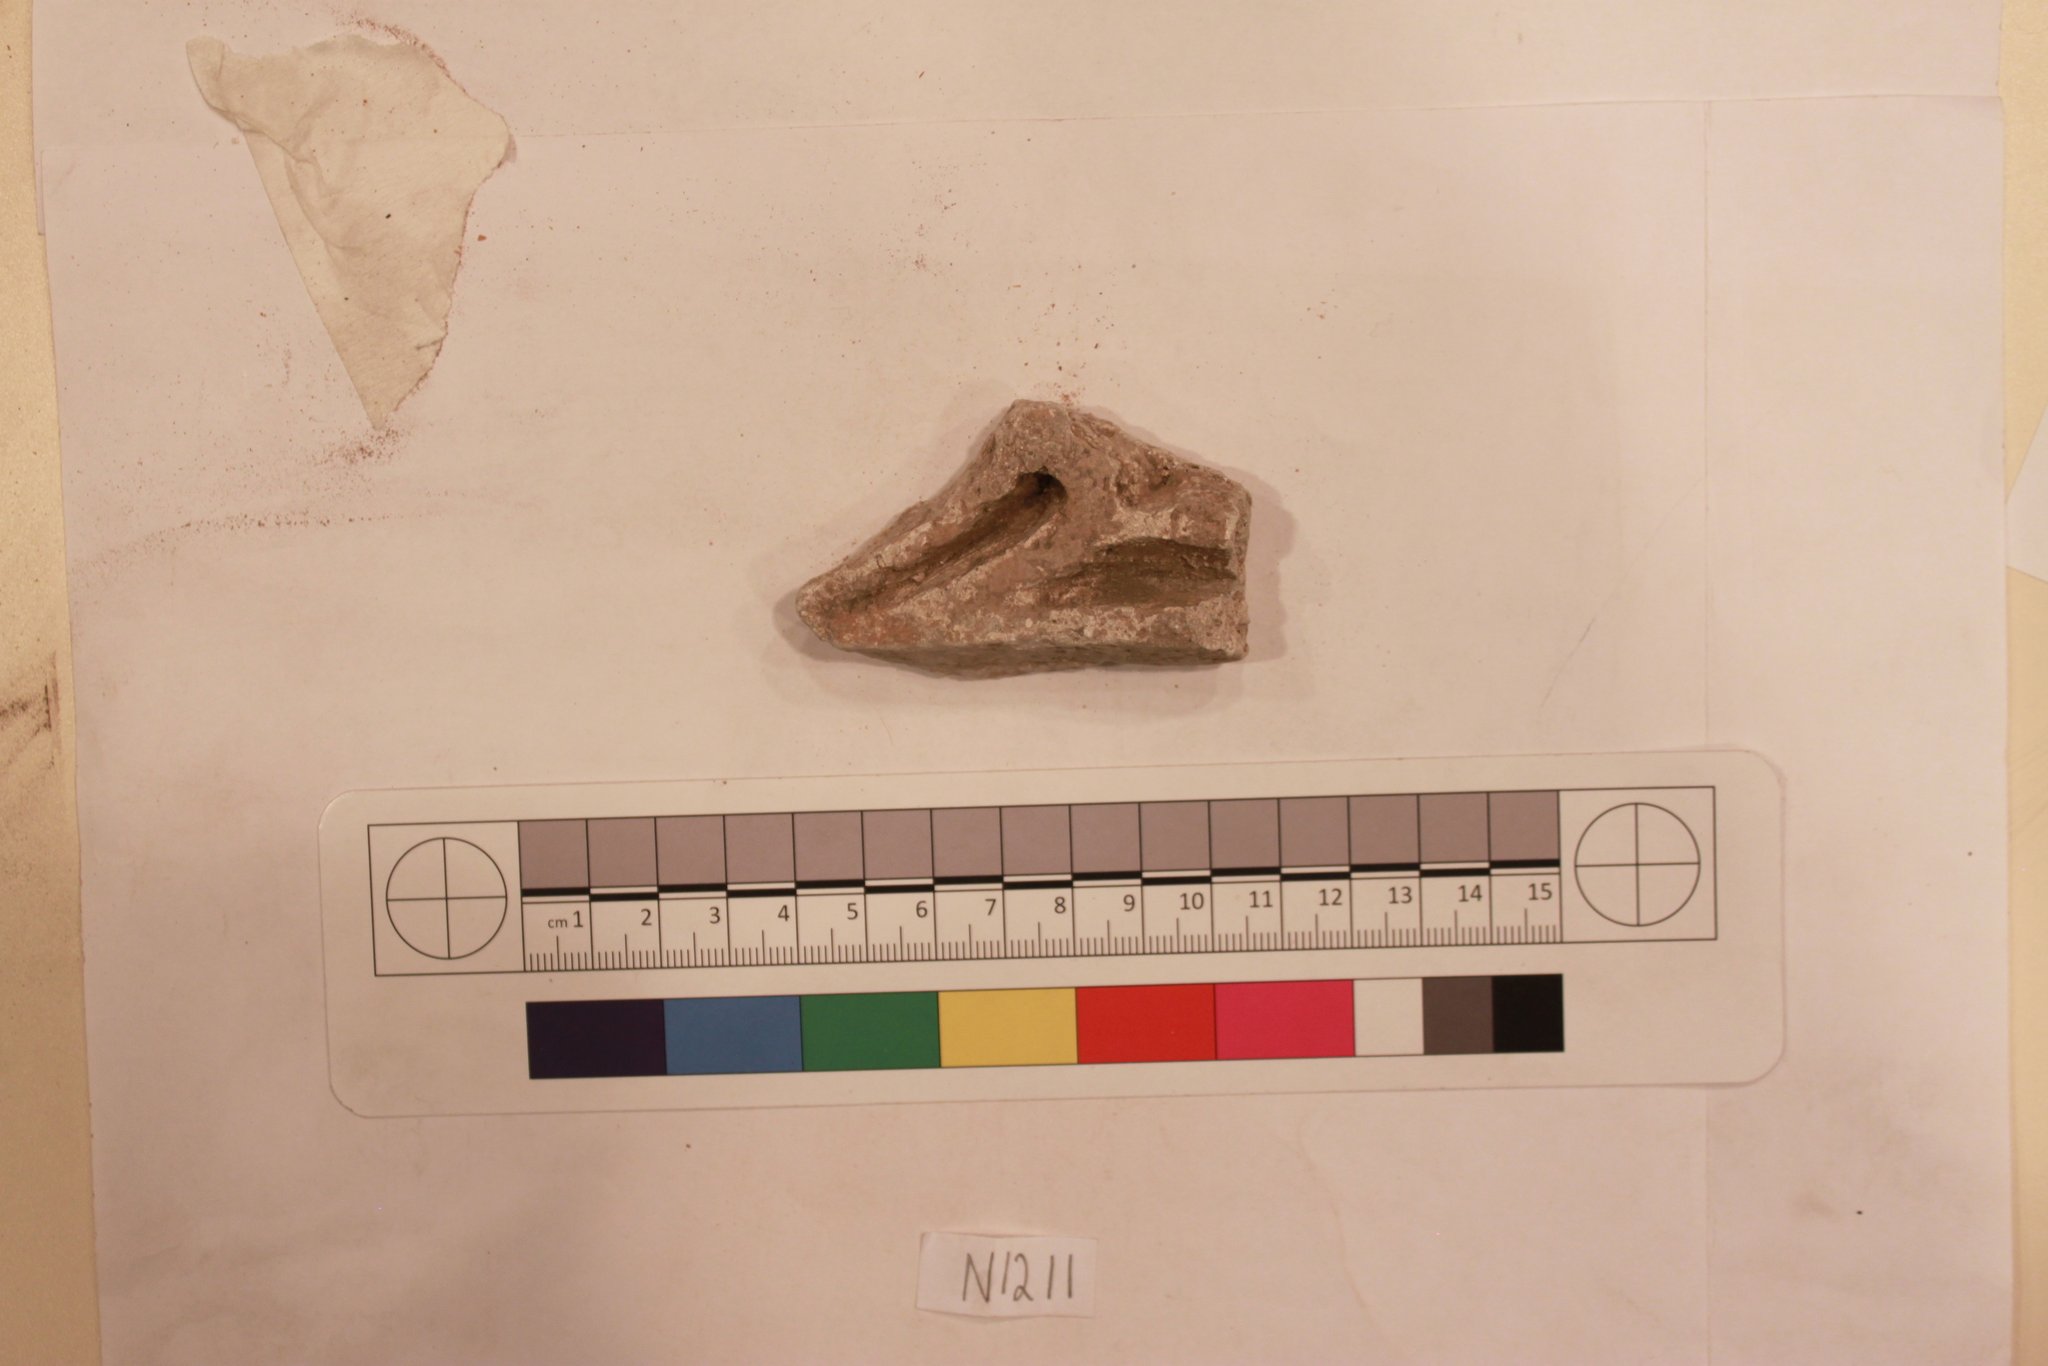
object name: fragment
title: Stucco Fragment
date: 701-1200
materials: plaster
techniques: carving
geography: iran